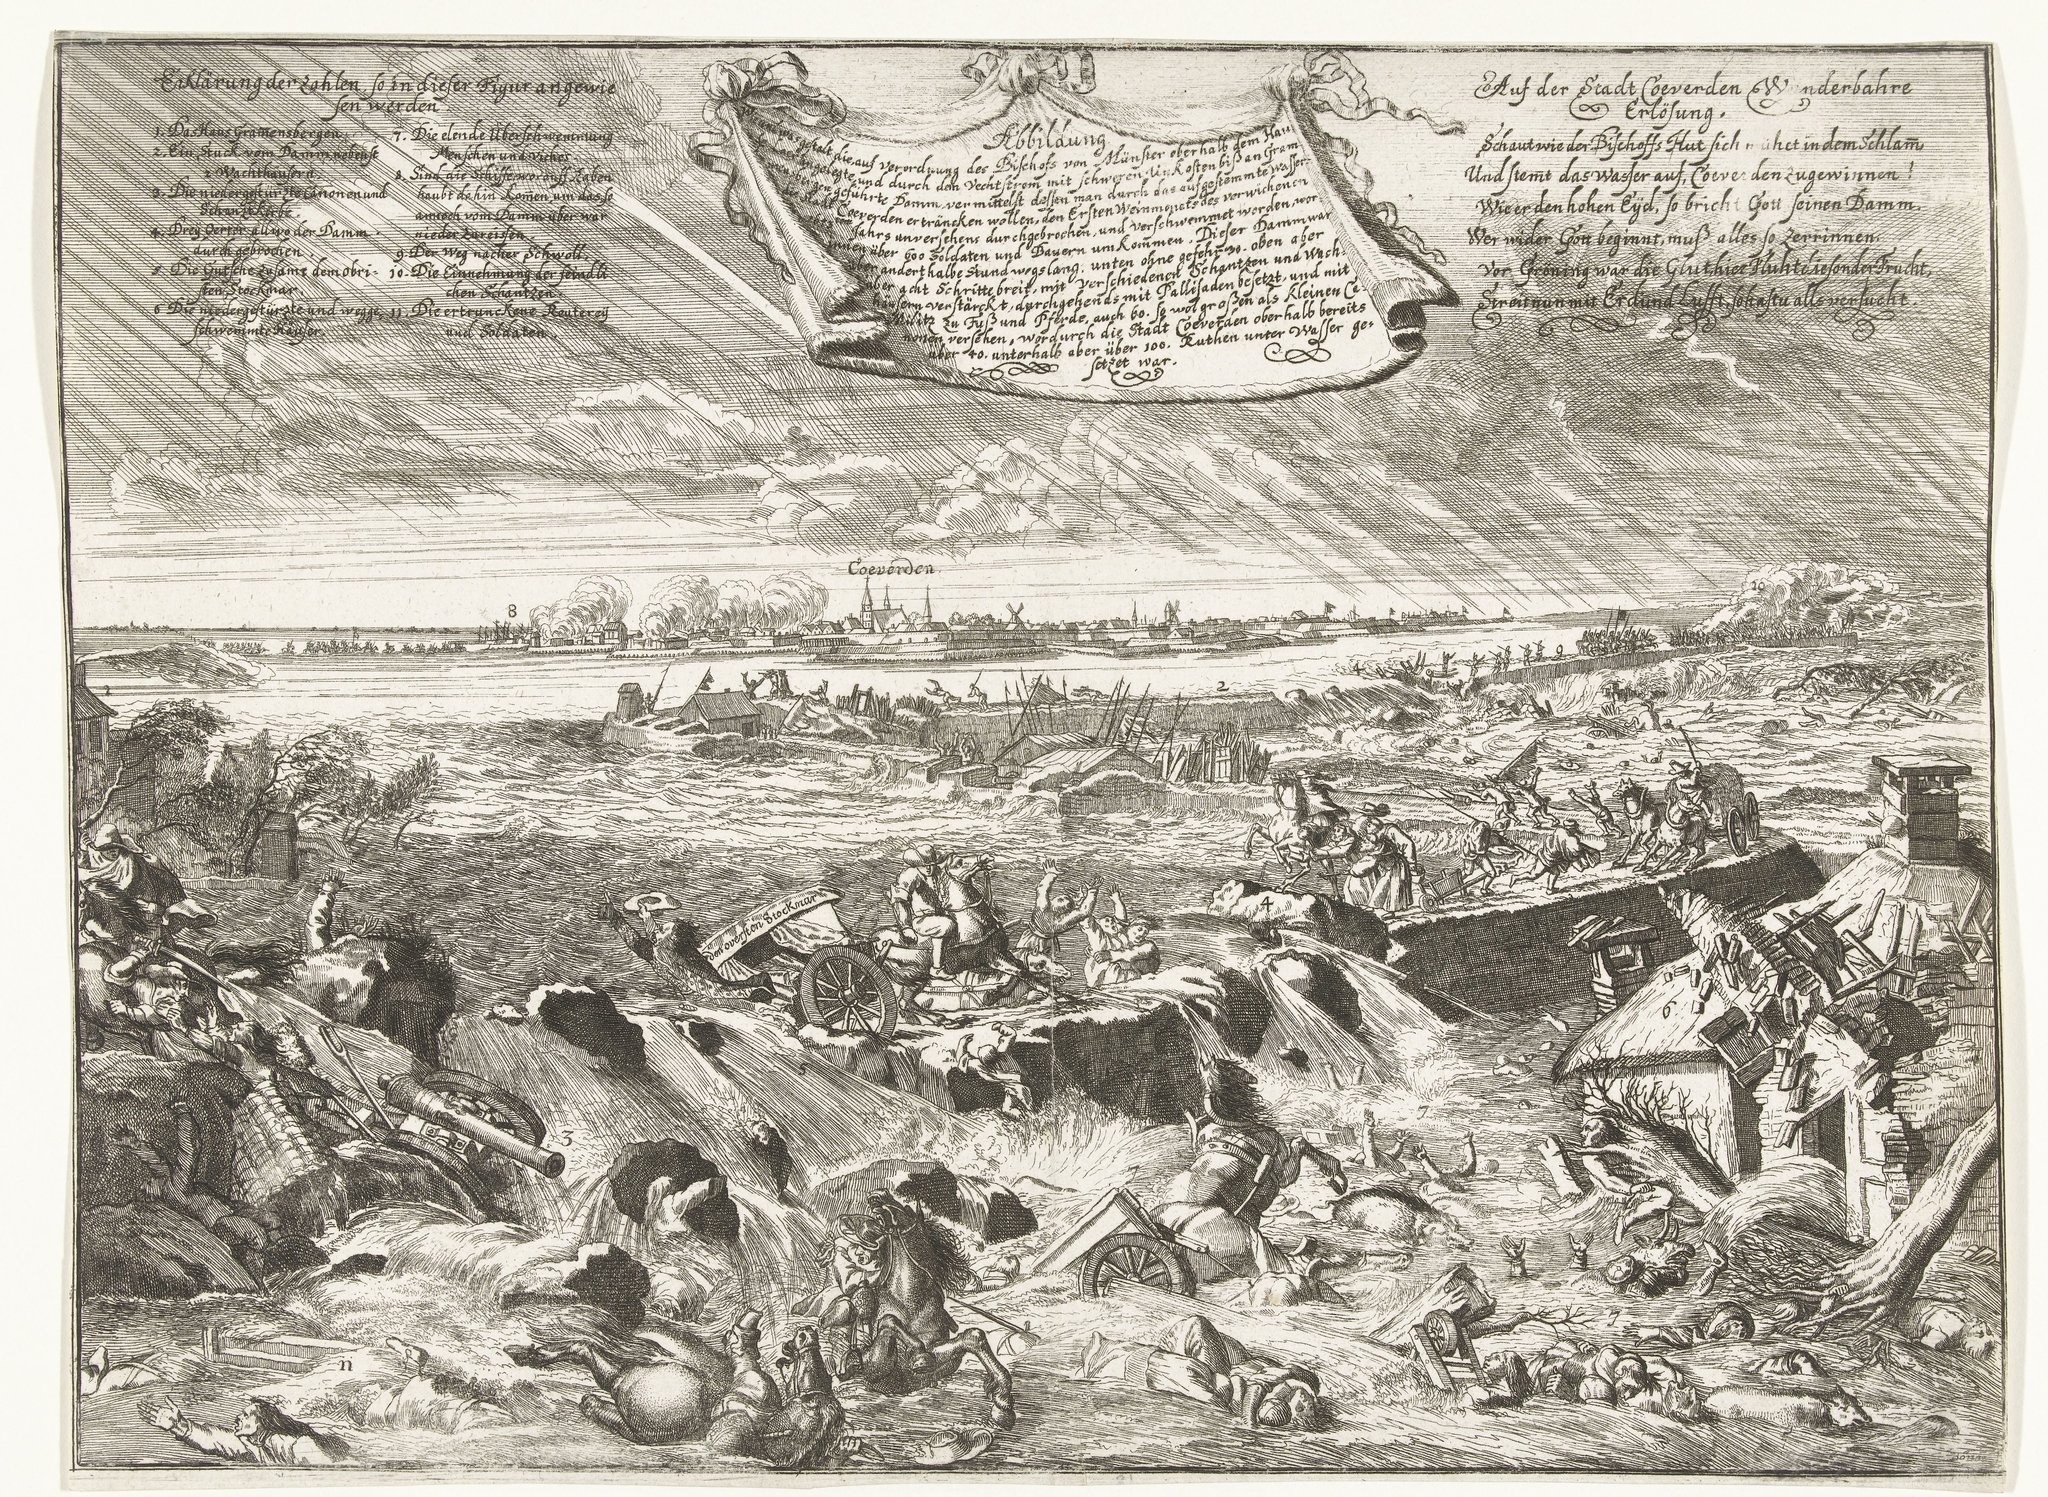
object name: print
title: Abbildung wie und was gestalt die, auf verordnung des Bischofs von Münster (...)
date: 1673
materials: paper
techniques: etching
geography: germany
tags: dike-break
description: Dijkdoorbraak bij Coevorden, 1 oktober 1673. Vijandelijke ruiters en geschut worden door het water weggespoeld, in de verte de stad Coevorden. Bovenin de plaat de in het Duits vertaalde titel op een hangende doek, links een legenda 1-11, rechts een vers van 6 regels 'Auf der Stadt Coeverden Wunderbahre Erlösung'.